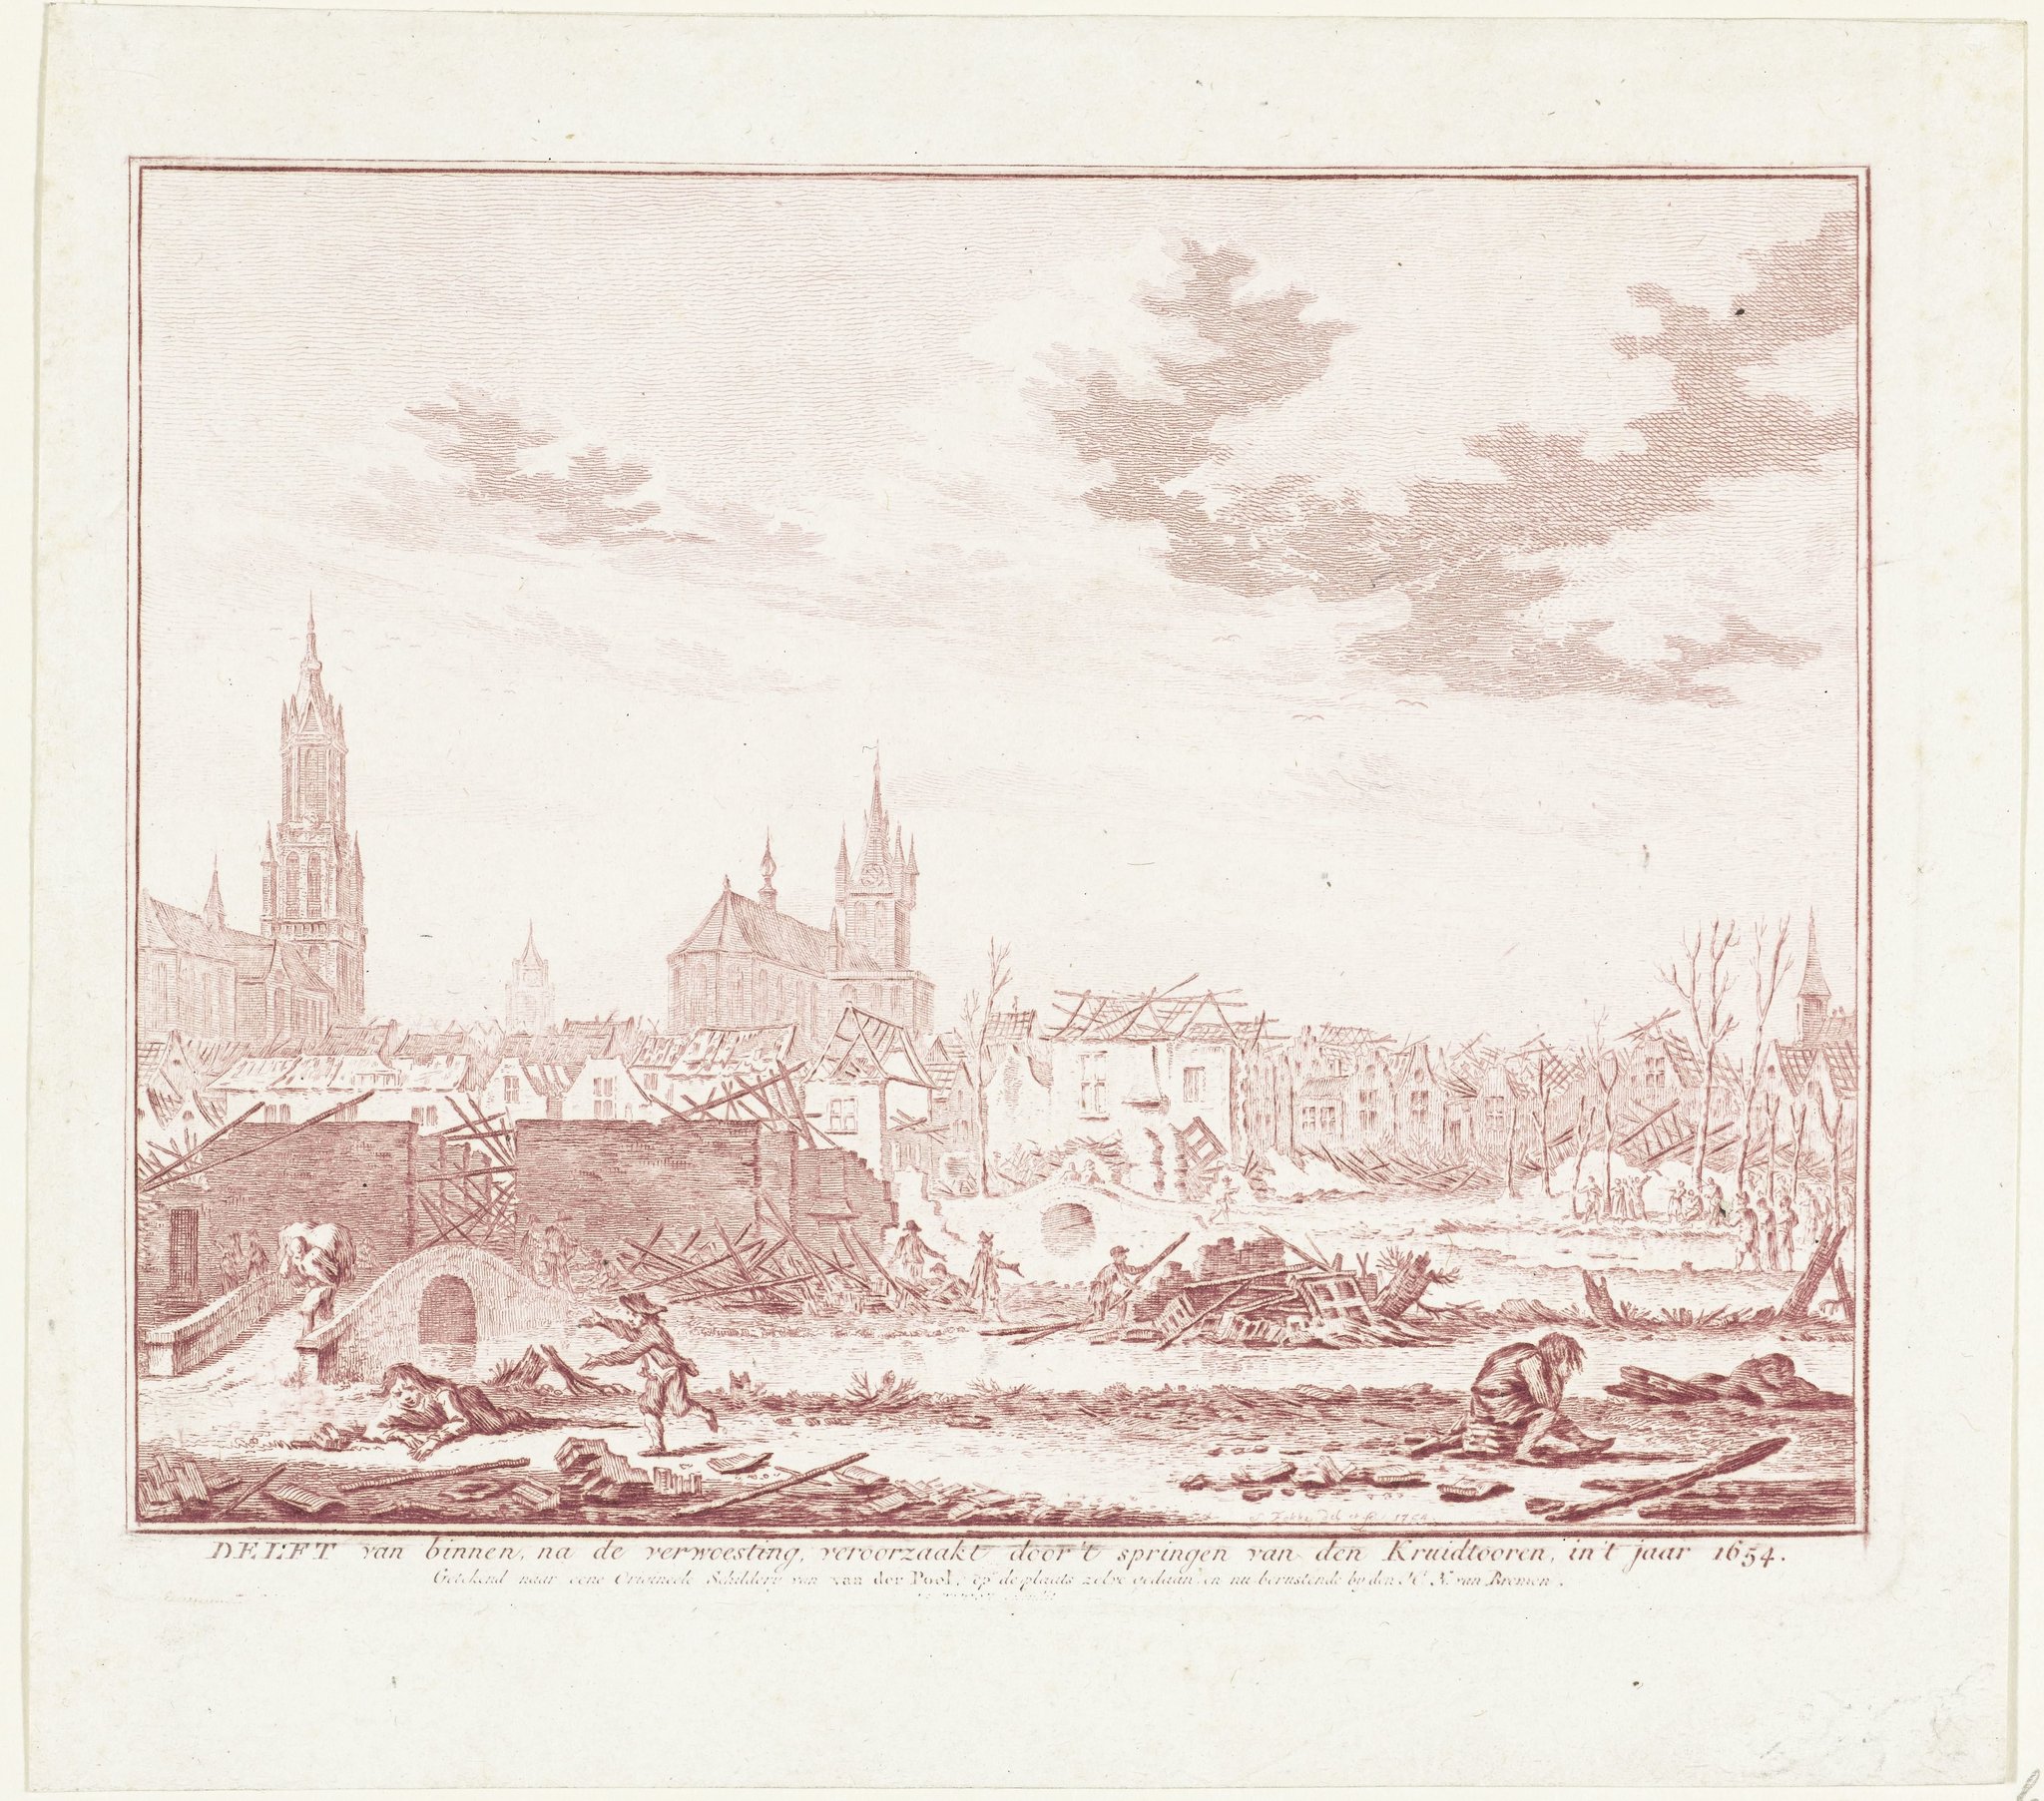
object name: print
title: Delft van binnen, na de verwoesting, veroorzaakt door 't springen van den Kruidtooren, in't jaar 1654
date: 1754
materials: paper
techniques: etching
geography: northern netherlands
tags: collapsing building, gunpowder disaster, delft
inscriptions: date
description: Gezicht op de verwoeste straten en huizen in Delft na de ontploffing van het buskruitmagazijn op 12 oktober 1654. Op de grond zitten en liggen gewonde mensen. Links de Oude en de Nieuwe Kerk.